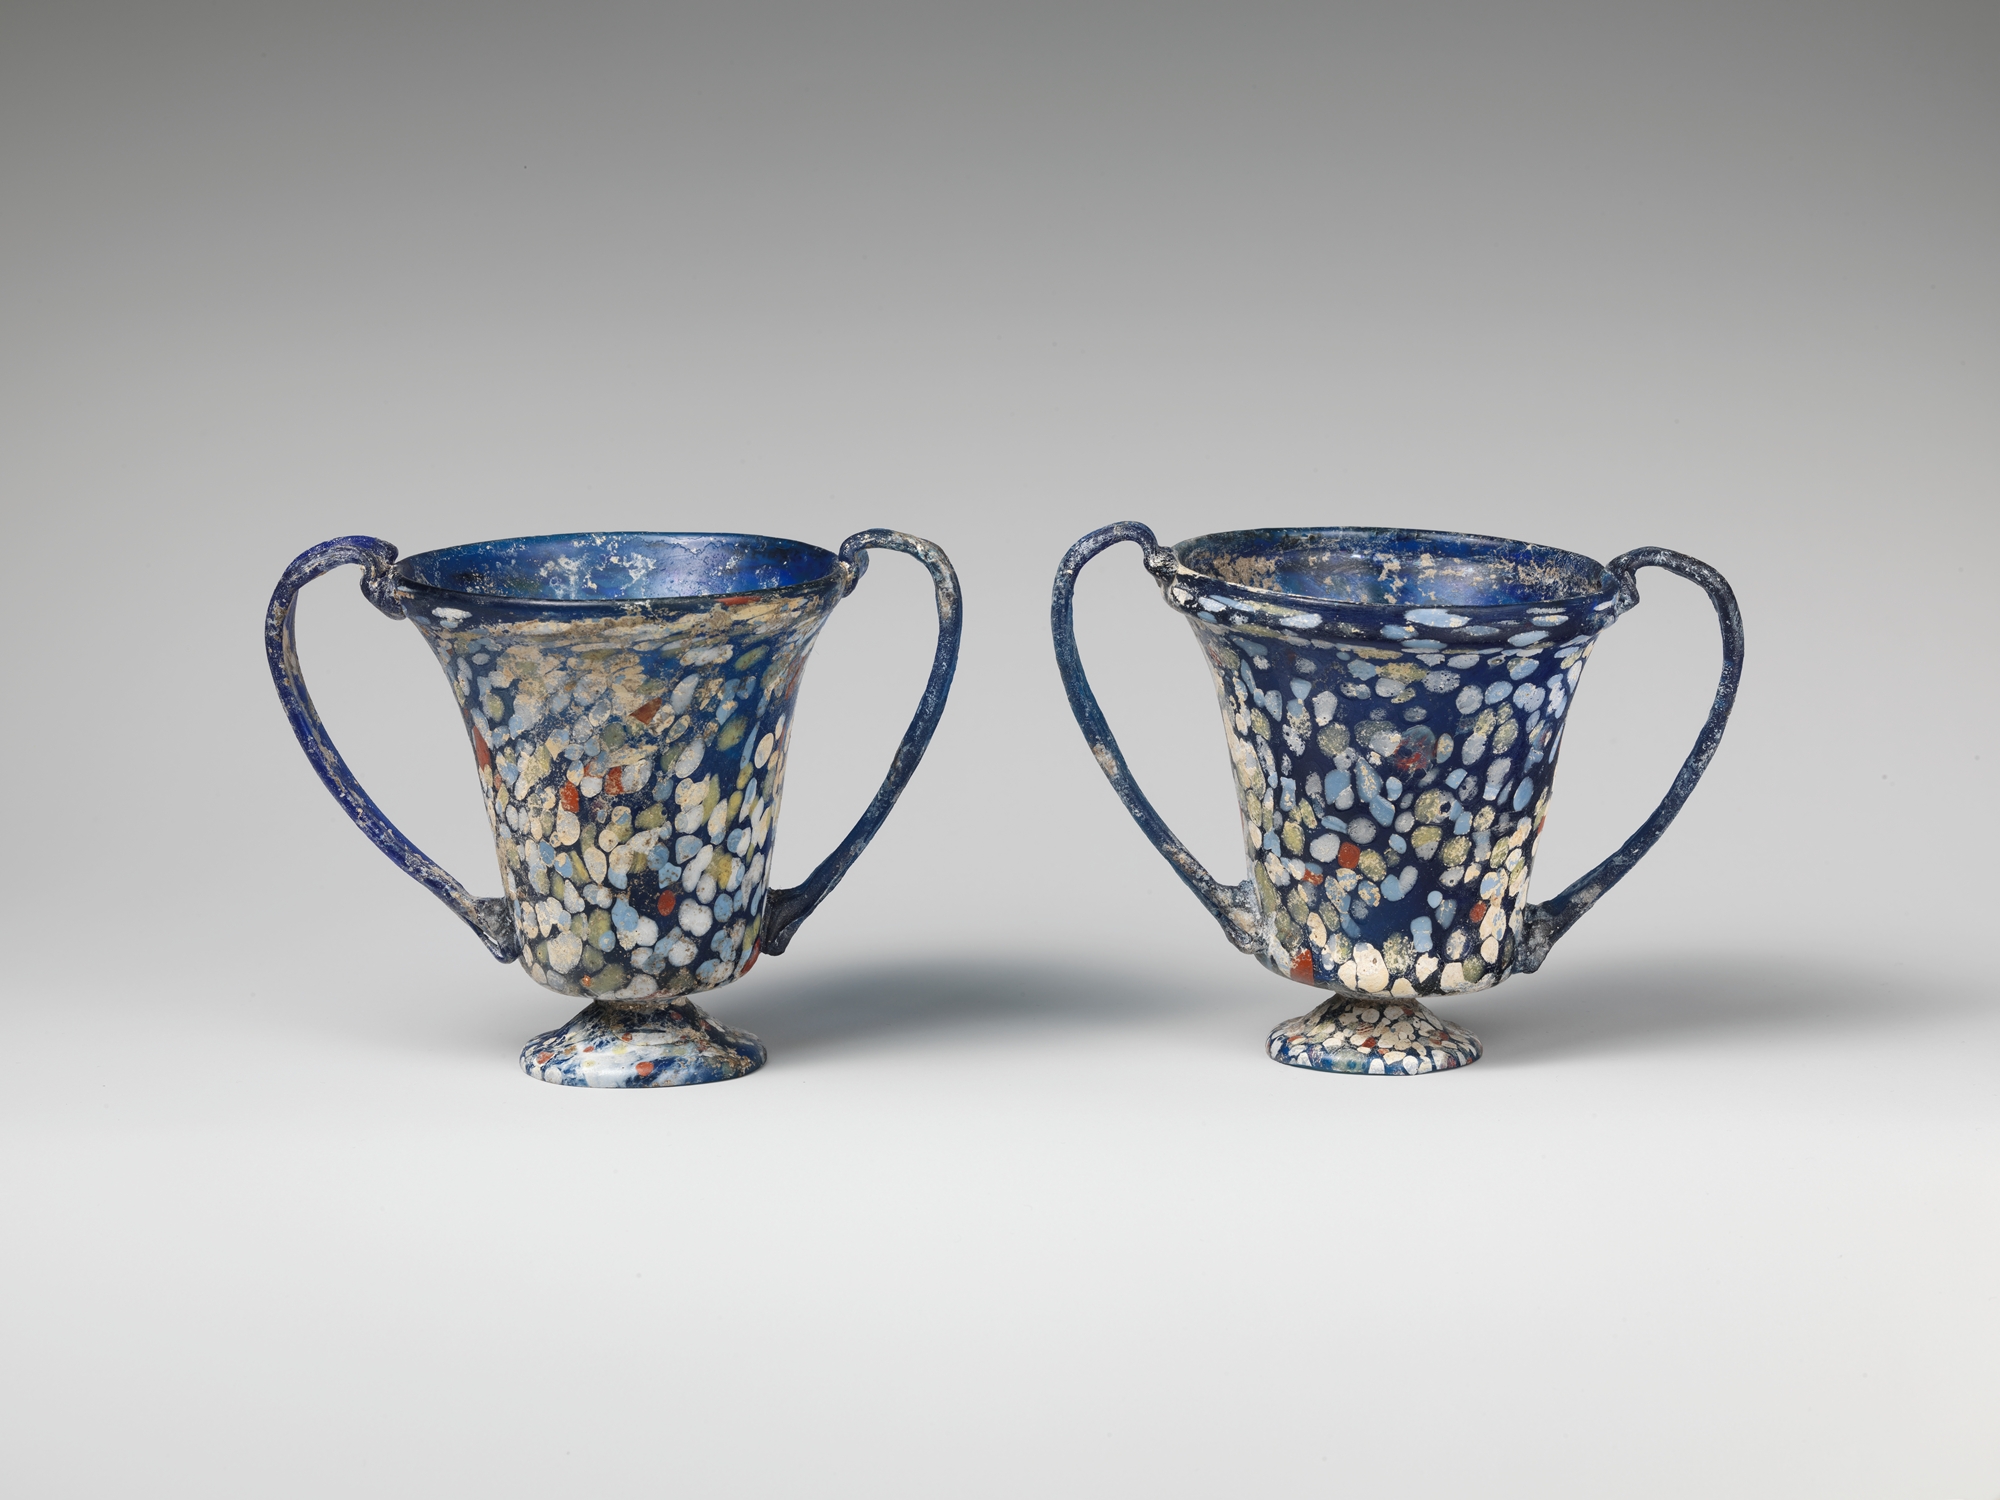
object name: cup, pair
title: A pair of glass drinking cups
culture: roman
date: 1-100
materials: glass